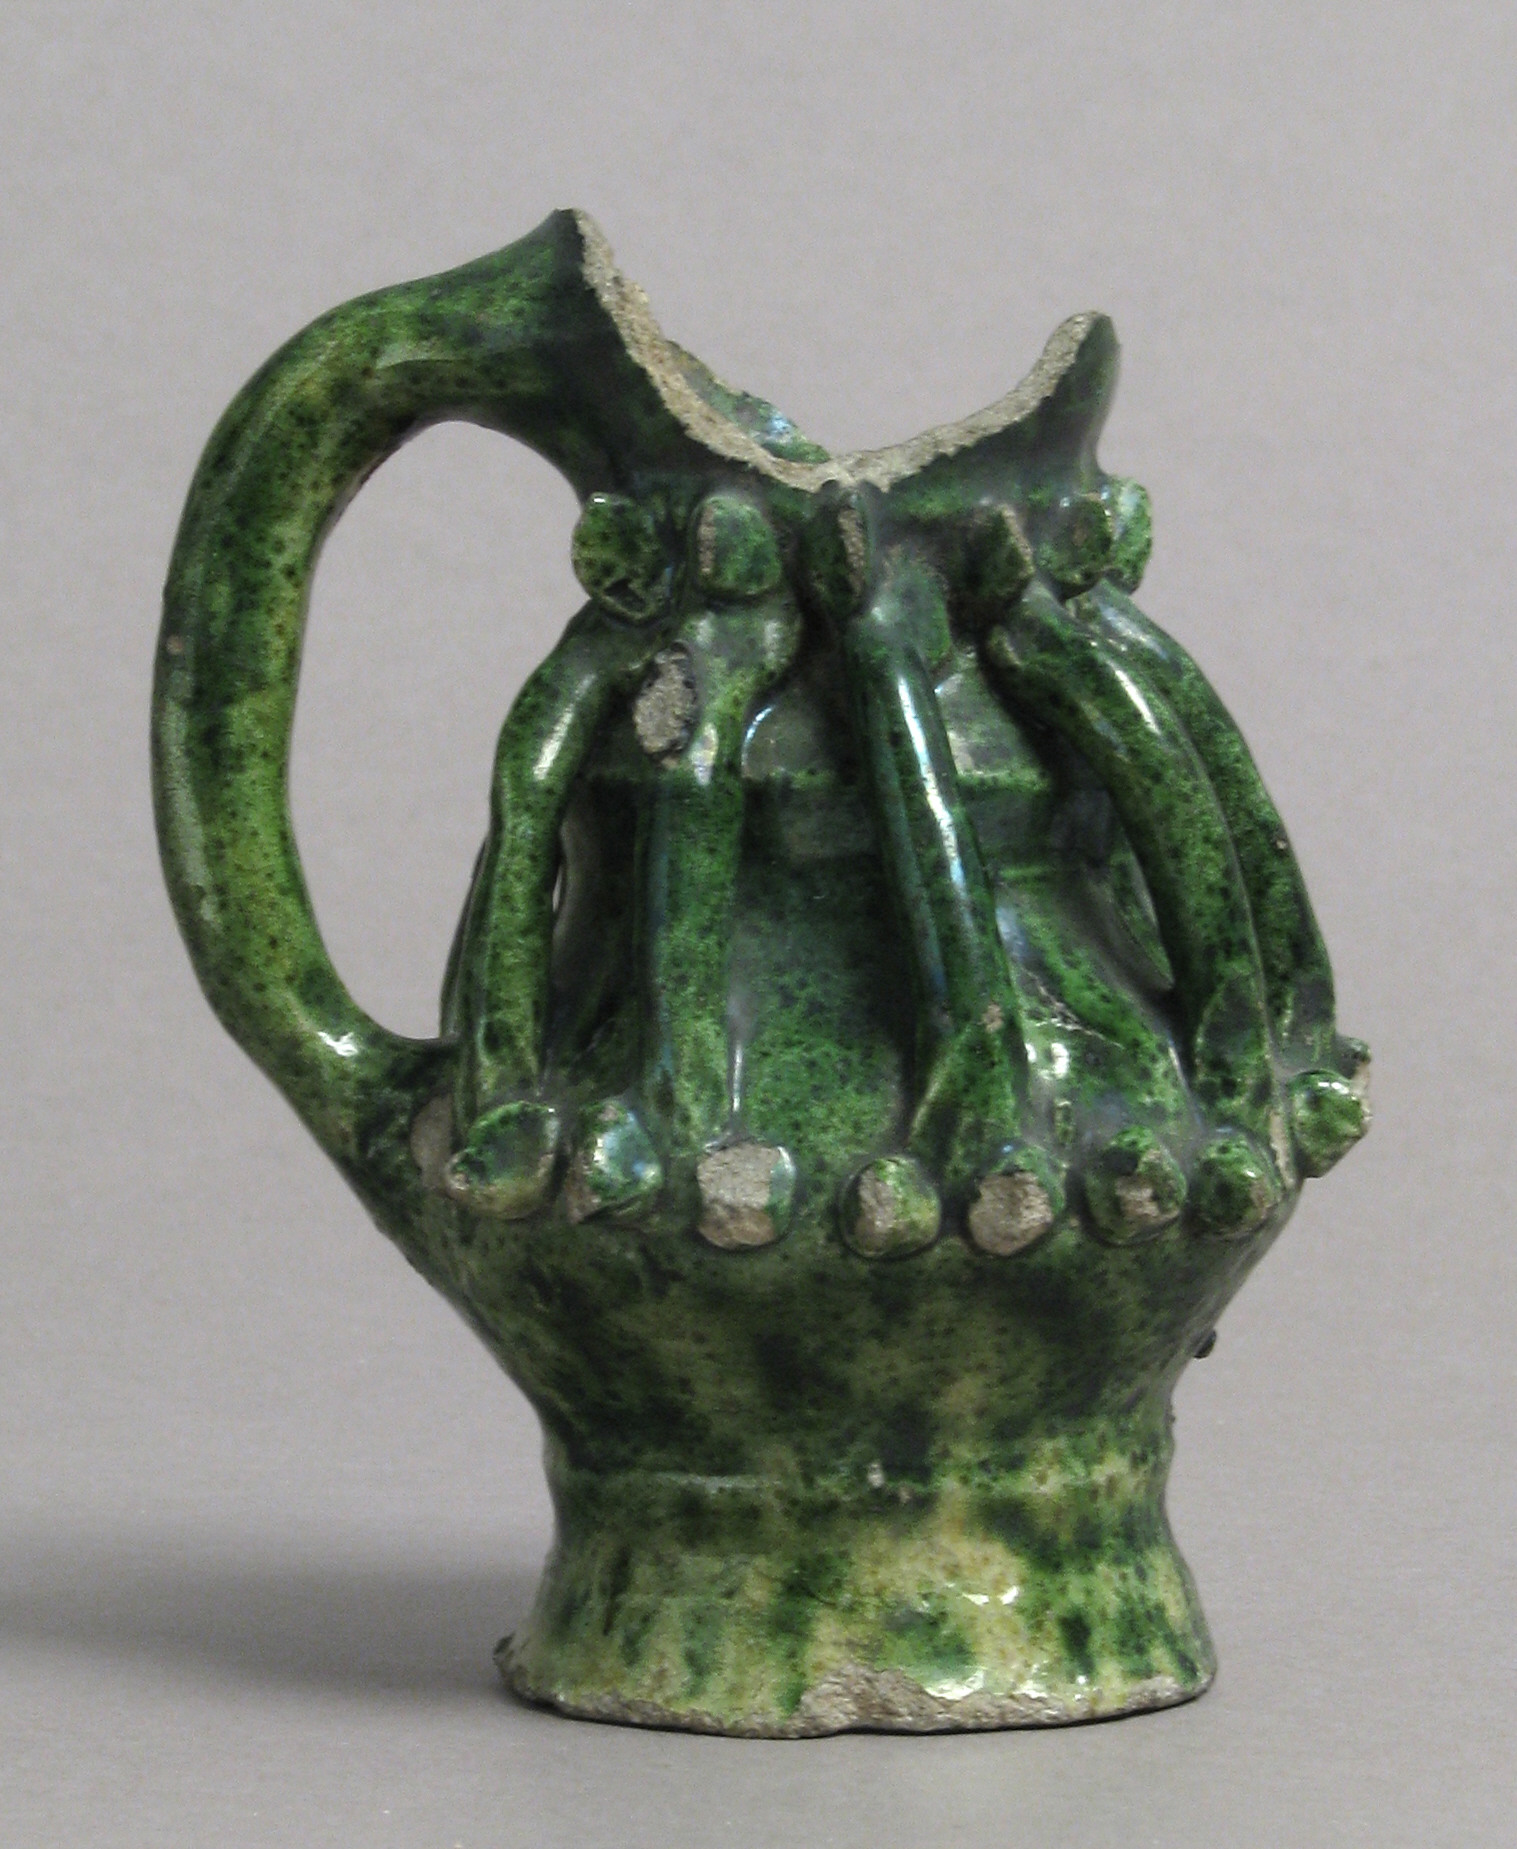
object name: jar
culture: european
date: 1301-1500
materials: earthenware, glaze